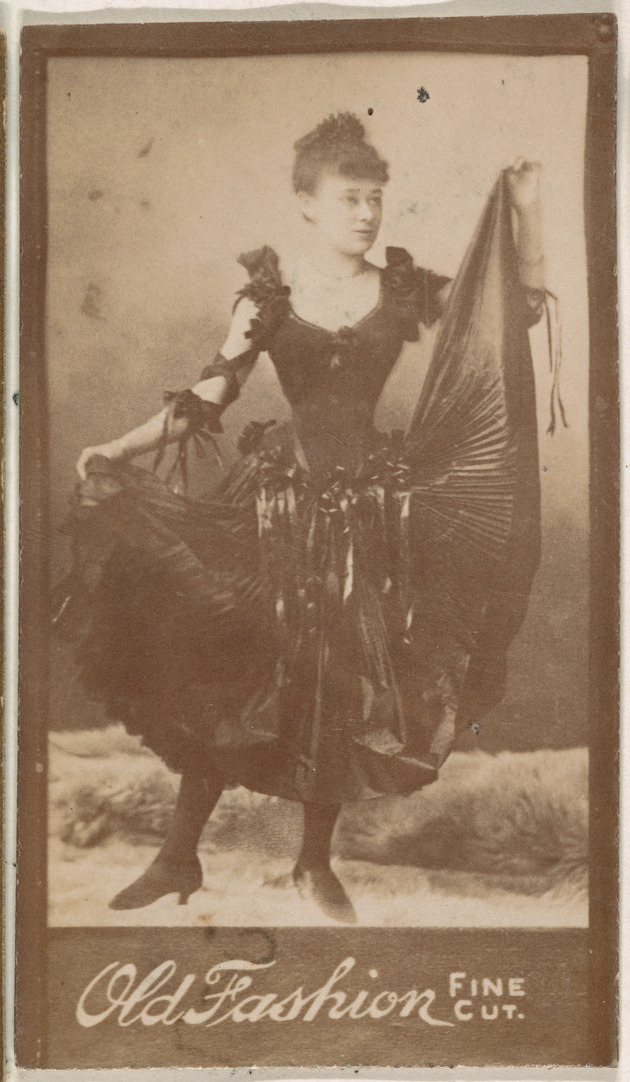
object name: photograph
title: Dancer, from the Actresses series (N664) promoting Old Fashion Fine Cut Tobacco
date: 1888-1890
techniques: albumen silver print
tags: portraits,women,actresses,dancers